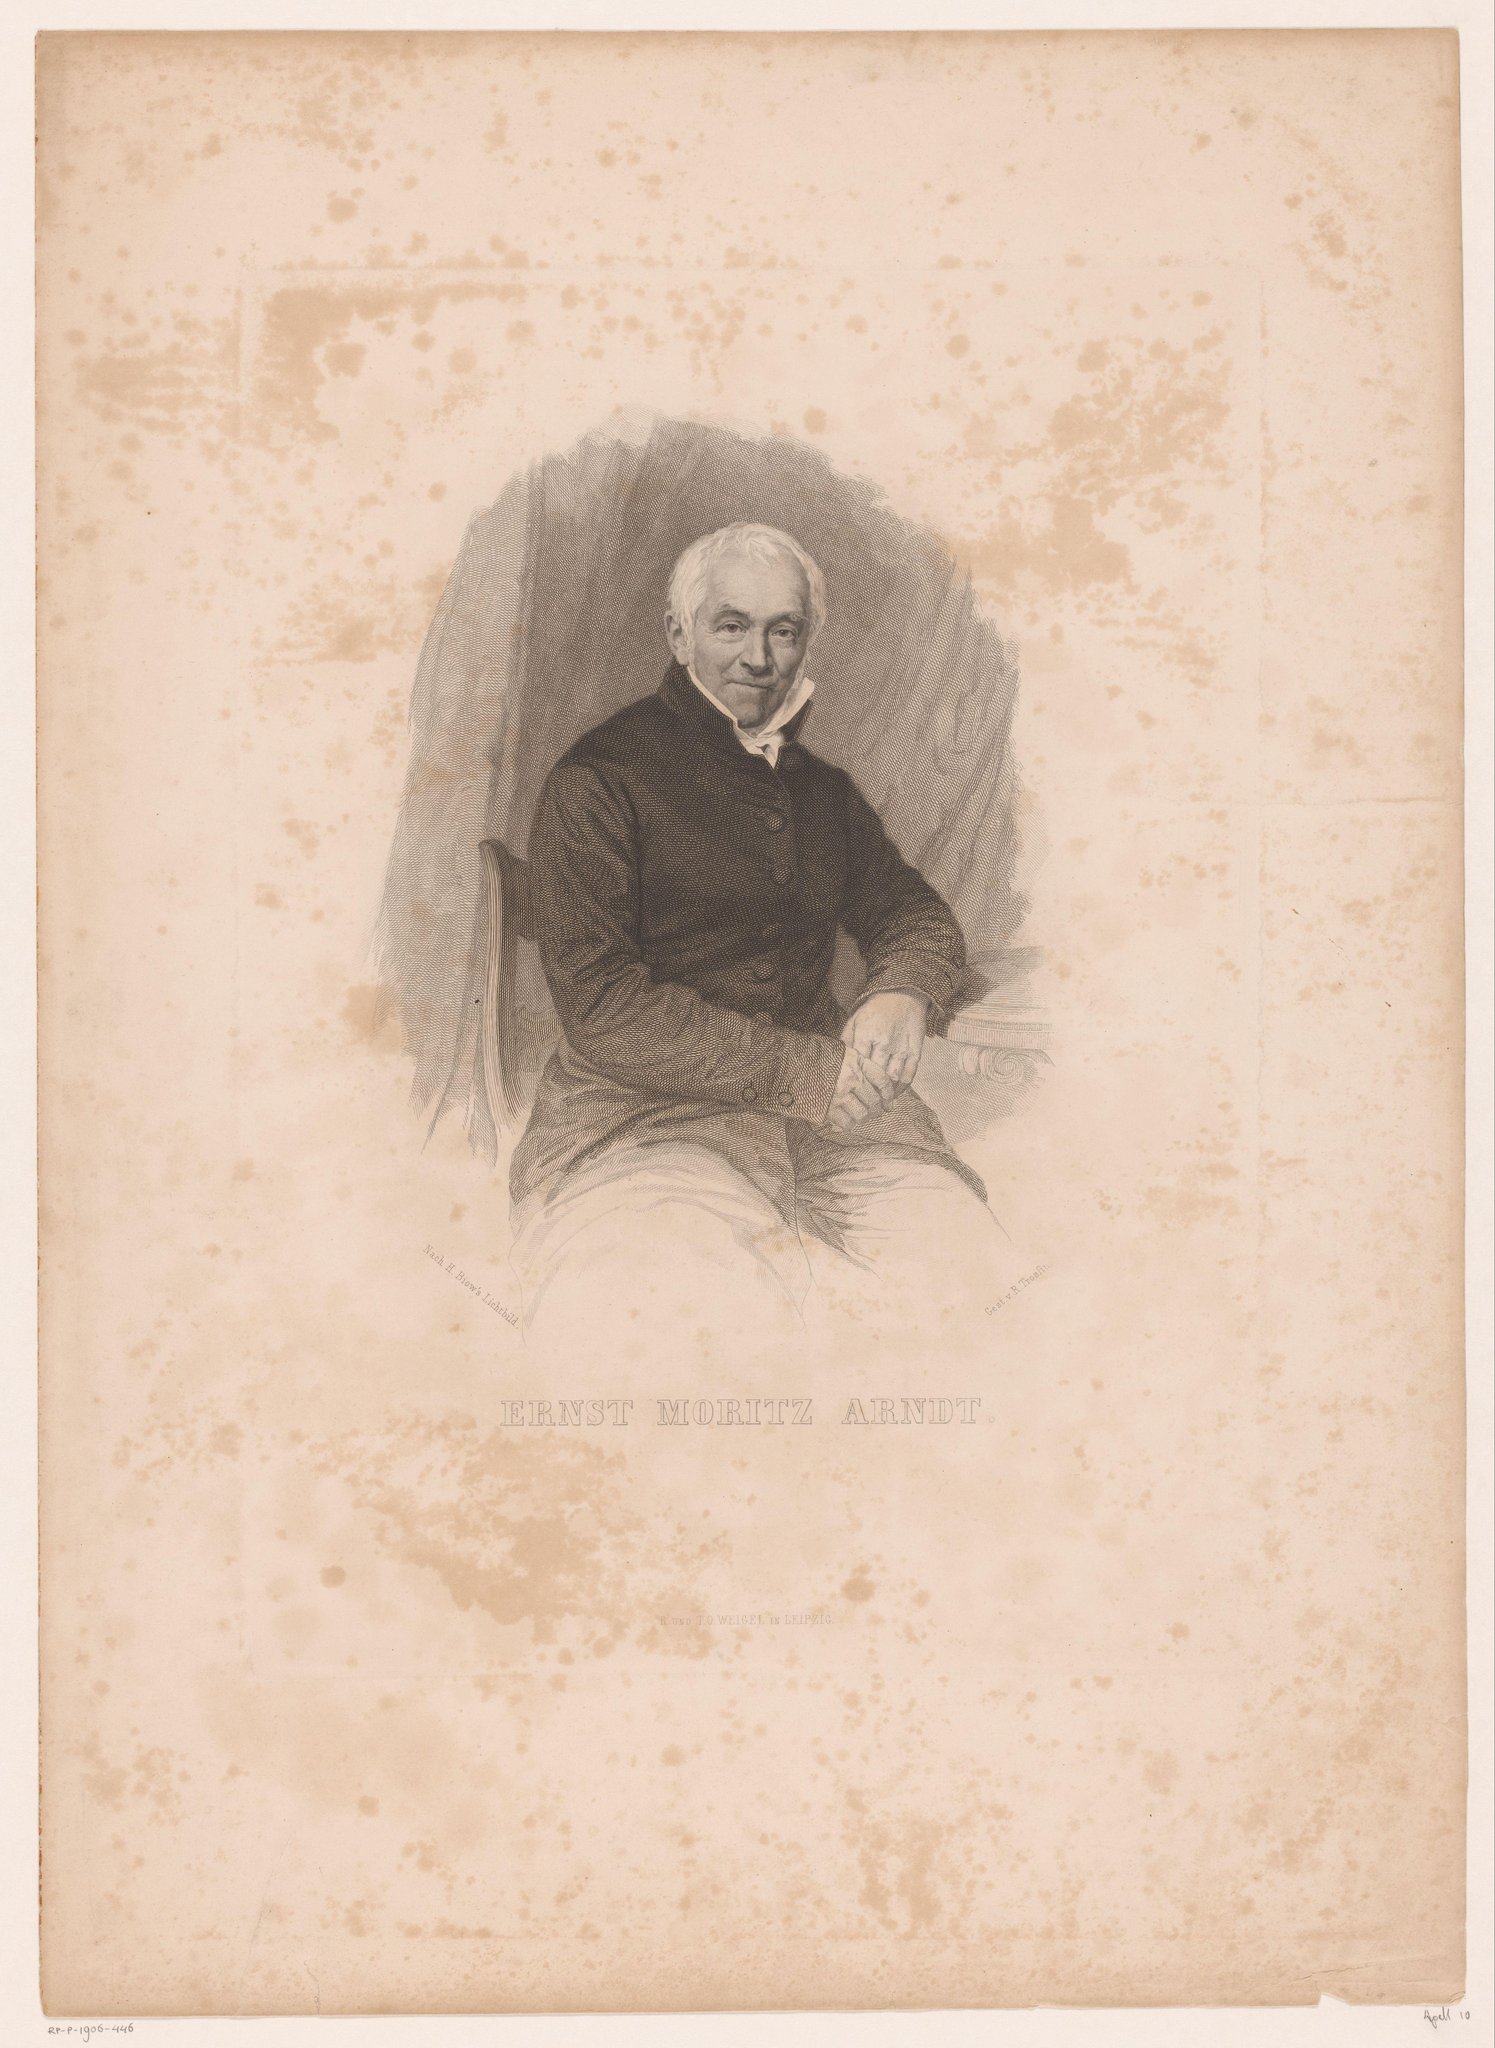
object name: print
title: Portret van Ernst Moritz Arndt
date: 1830-1896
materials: paper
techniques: engraving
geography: germany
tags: historical persons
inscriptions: collector's mark: Lugt 2228